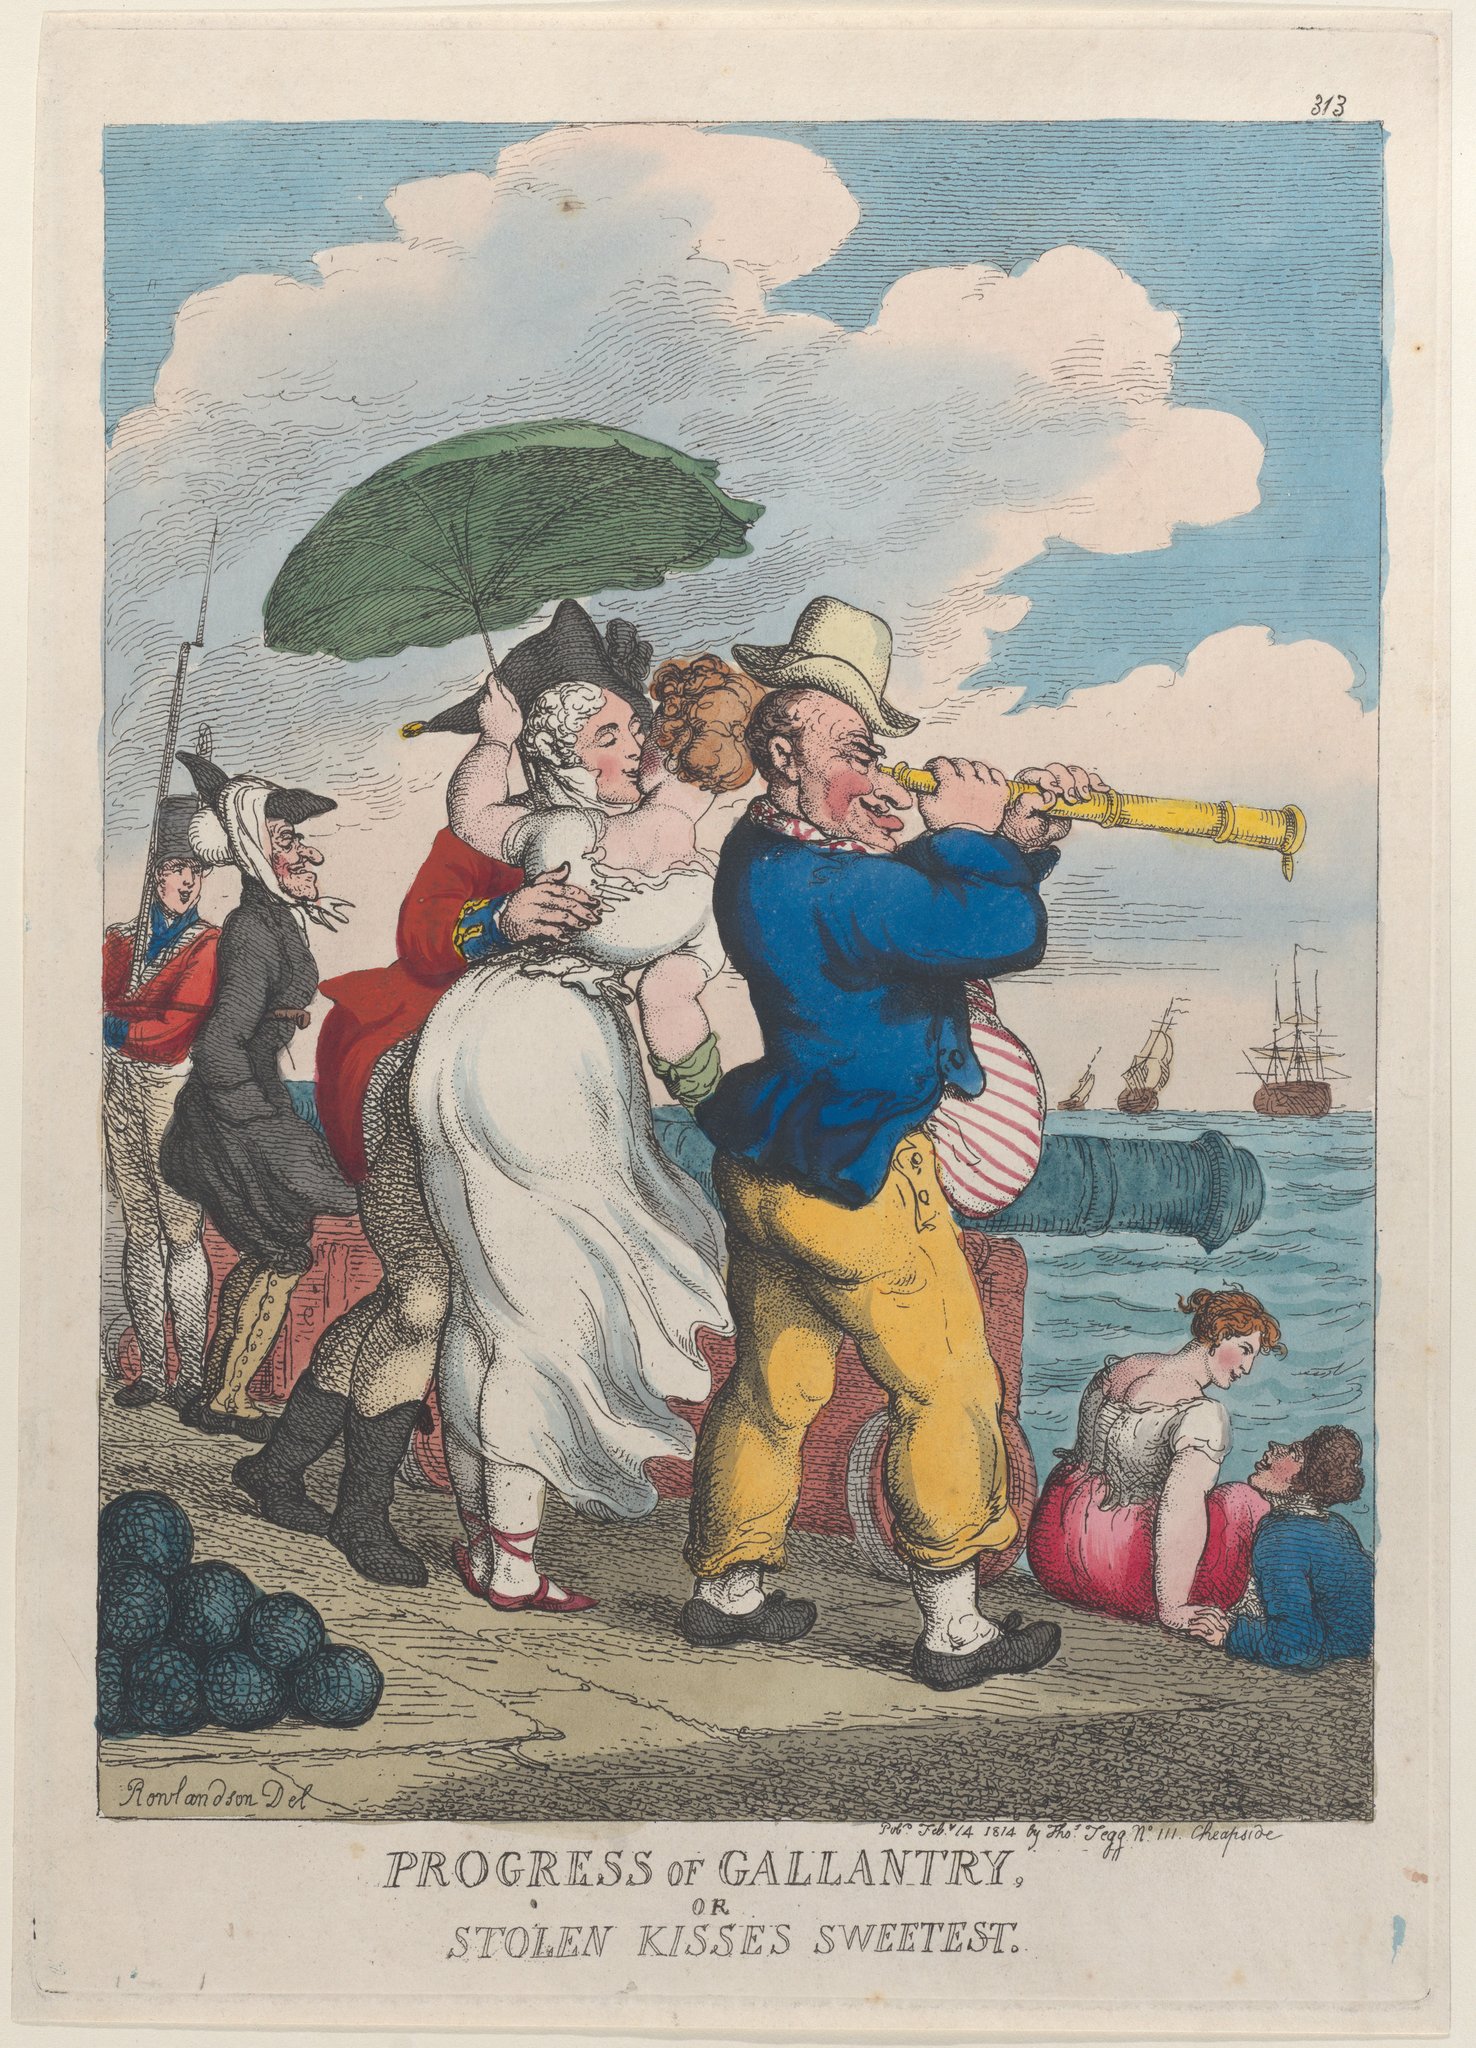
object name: print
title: Progress of Gallantry or Stolen Kisses Sweetest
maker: thomas rowlandson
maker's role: artist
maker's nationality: british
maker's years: 1757-1827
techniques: etching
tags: satire,couples,men,women,telescopes